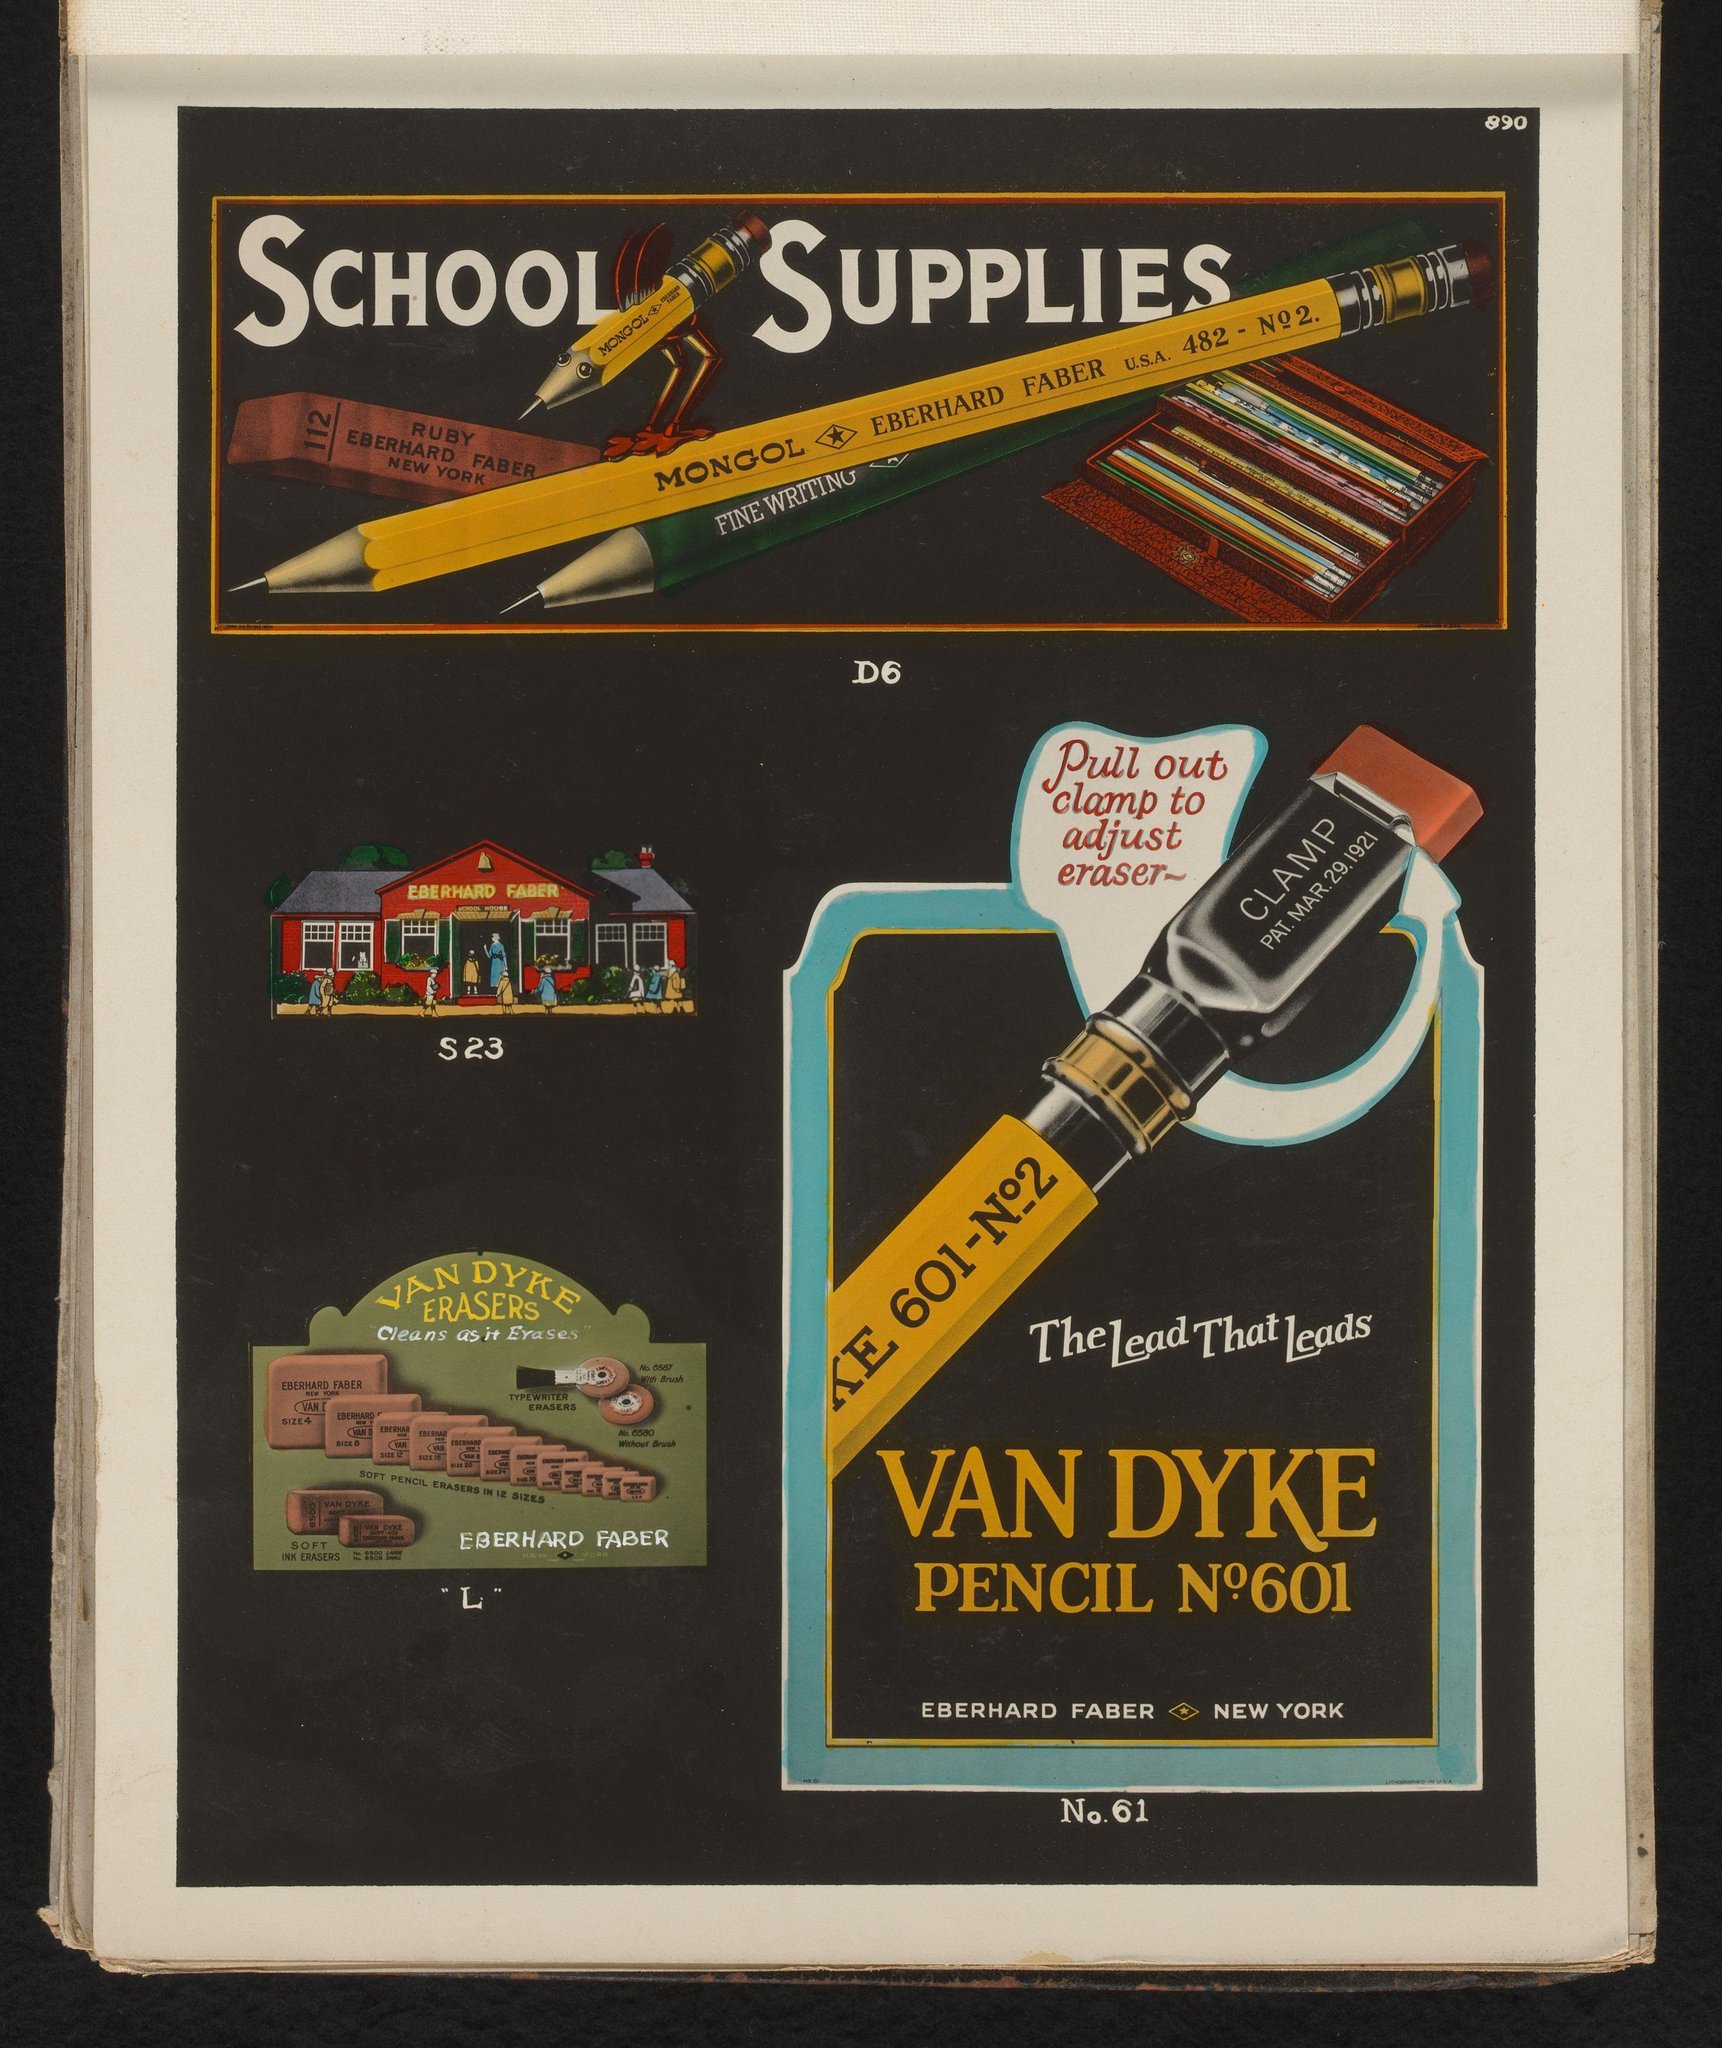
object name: photograph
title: Reclame voor potloden van Eberhard Faber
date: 1915-1935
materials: paper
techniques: gelatin silver print, hand coloring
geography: springfield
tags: pencil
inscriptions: stamp: ‘Paramount/ Commercial Studios/ 145 Chestnut St./ Springfield - Mass.’, number: ‘890’